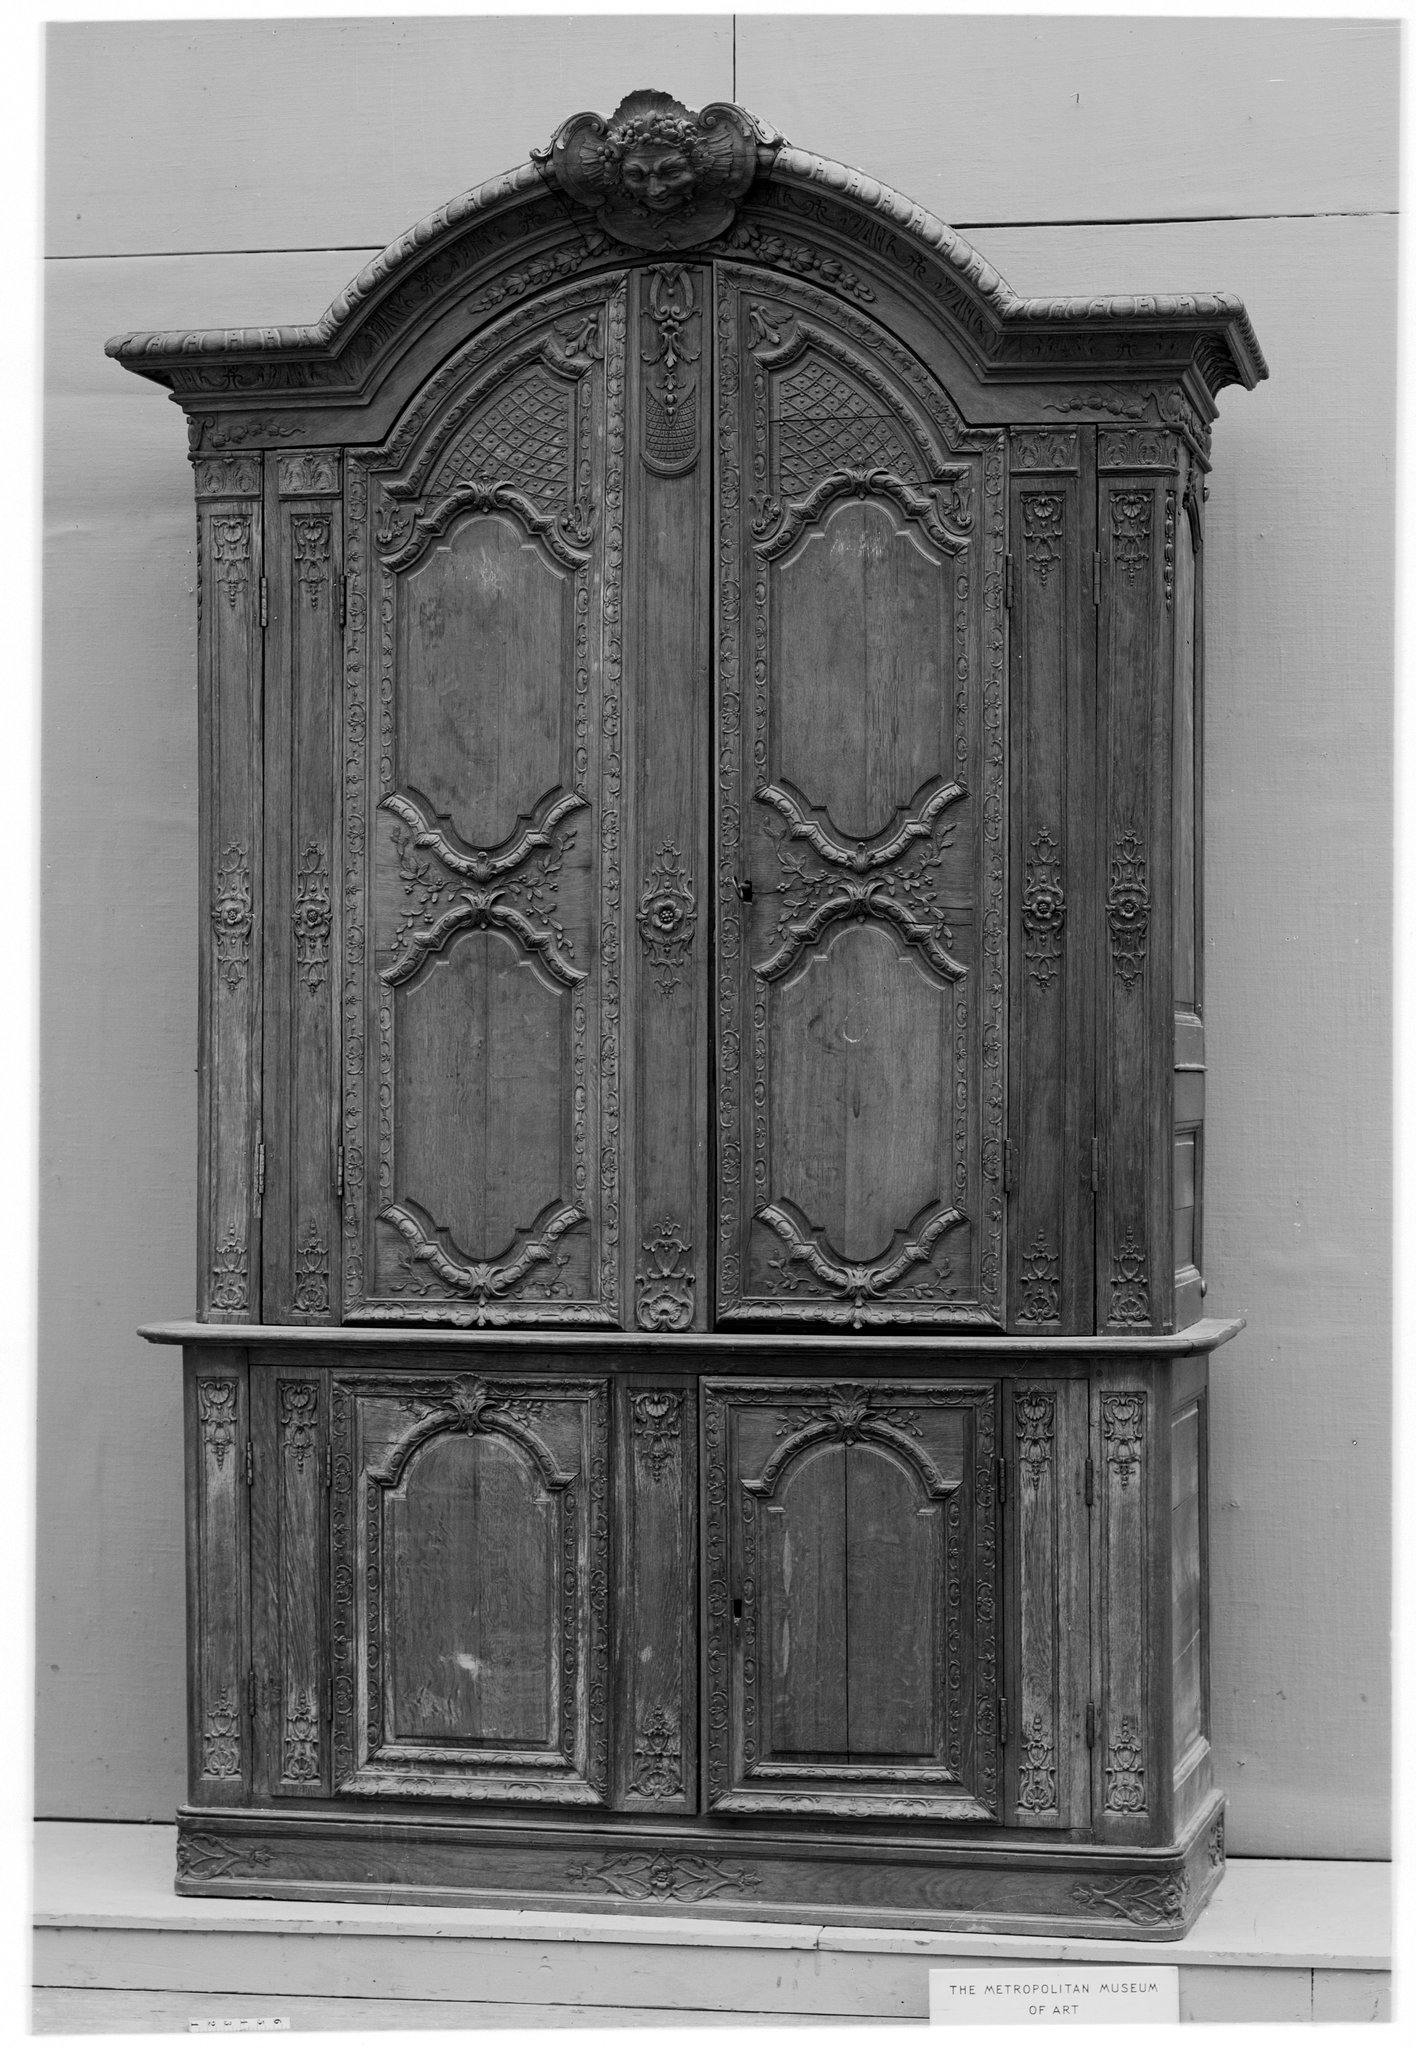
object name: armoire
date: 1667-1700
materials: wood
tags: faces,furniture